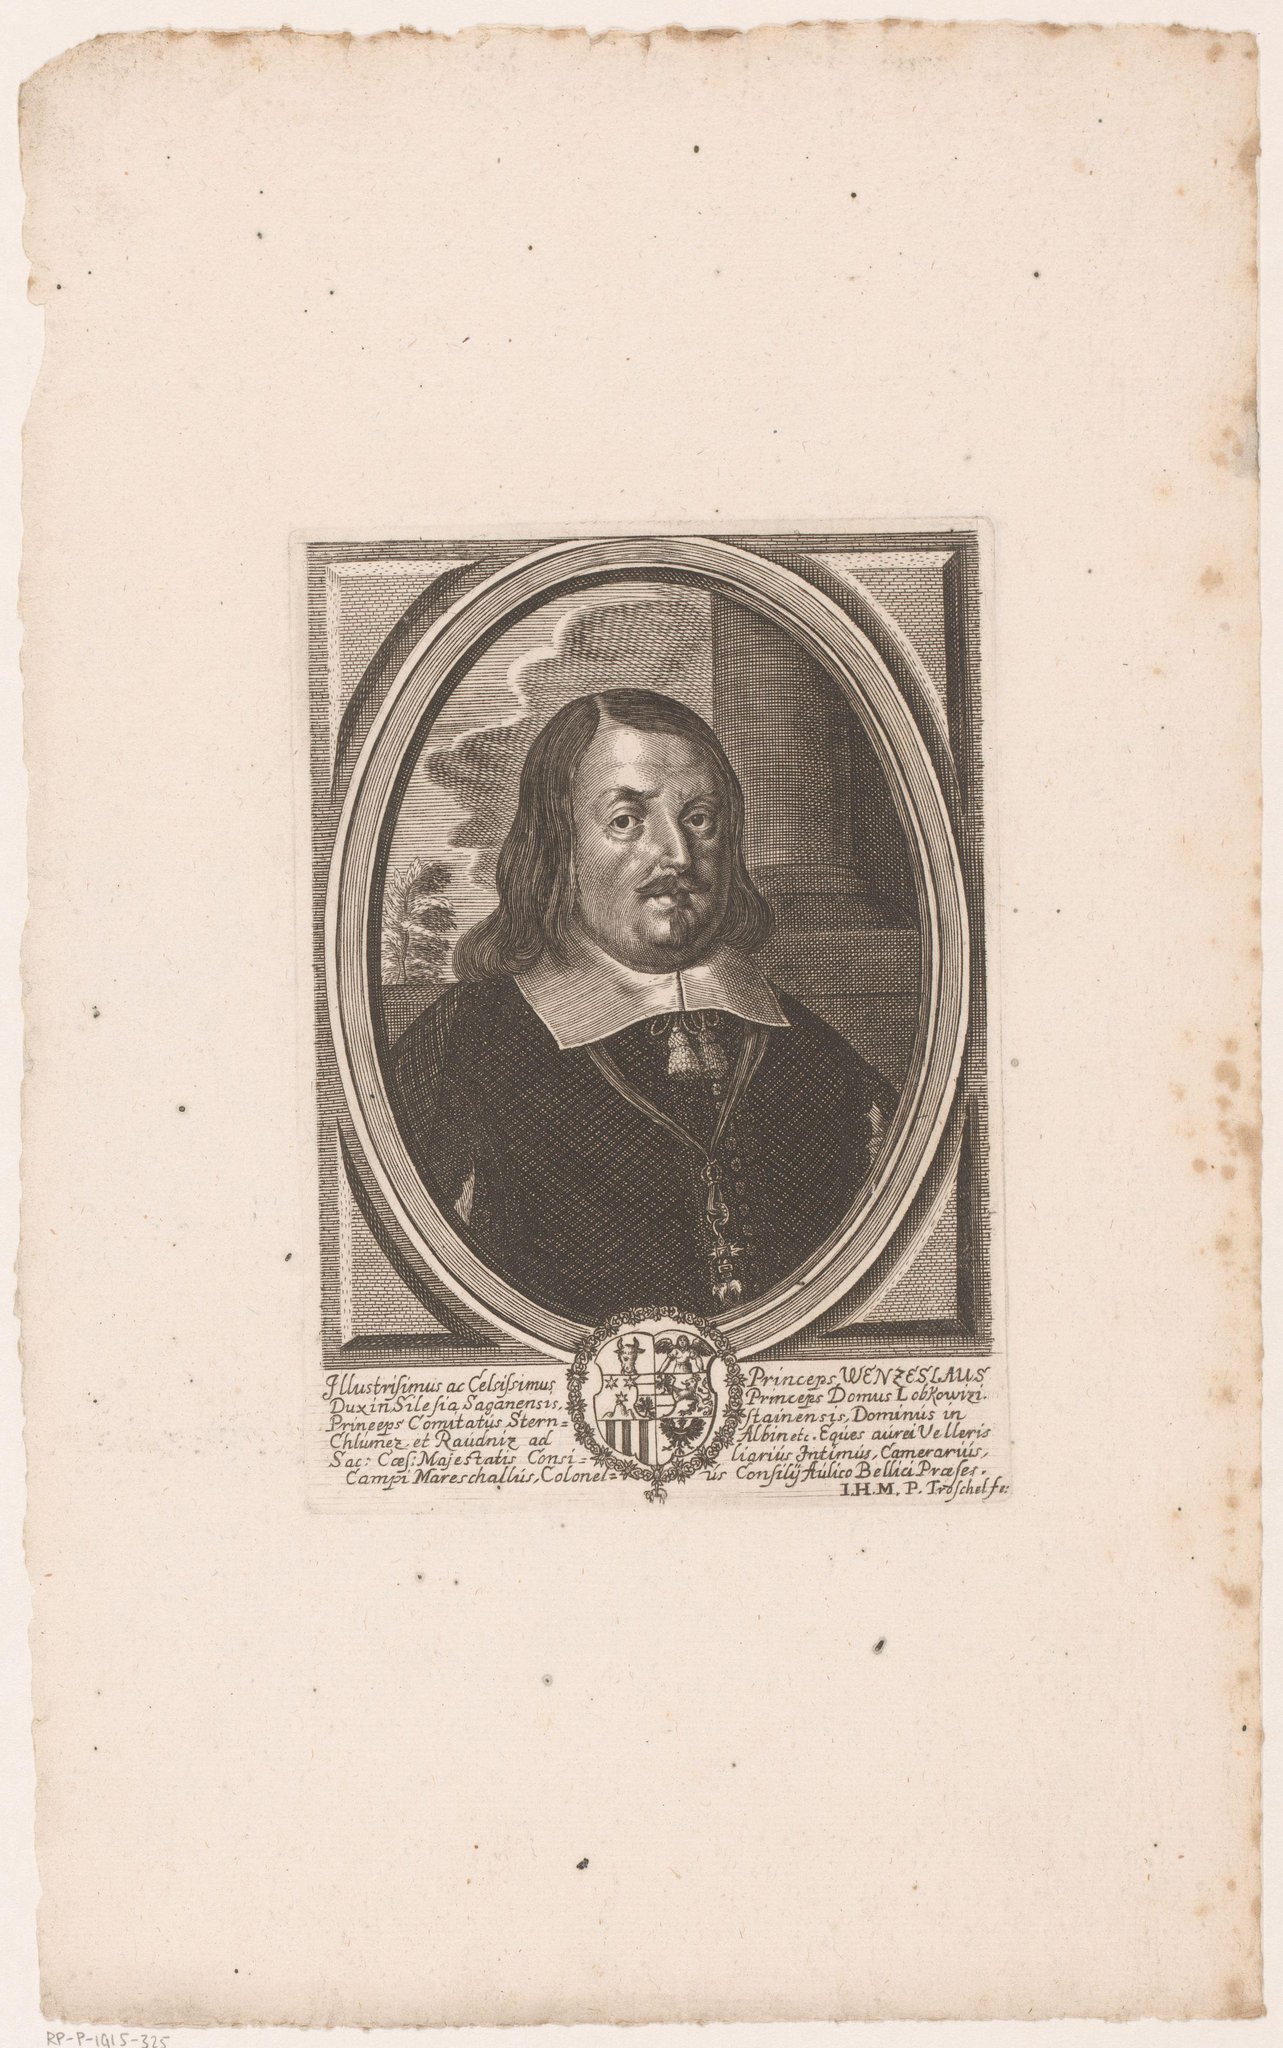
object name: print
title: Portret van Wenzel Eusebius von Lobkowitz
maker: peter troschel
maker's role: draughtsman, print maker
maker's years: 1620-1670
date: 1650-1670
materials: paper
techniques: engraving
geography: germany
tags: earl, historical persons, knighthood order of the golden fleece - insignia of a knighthood order, e.g.: badge, chain (with name of order), armorial bearing, heraldry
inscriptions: collector's mark: Lugt 2228